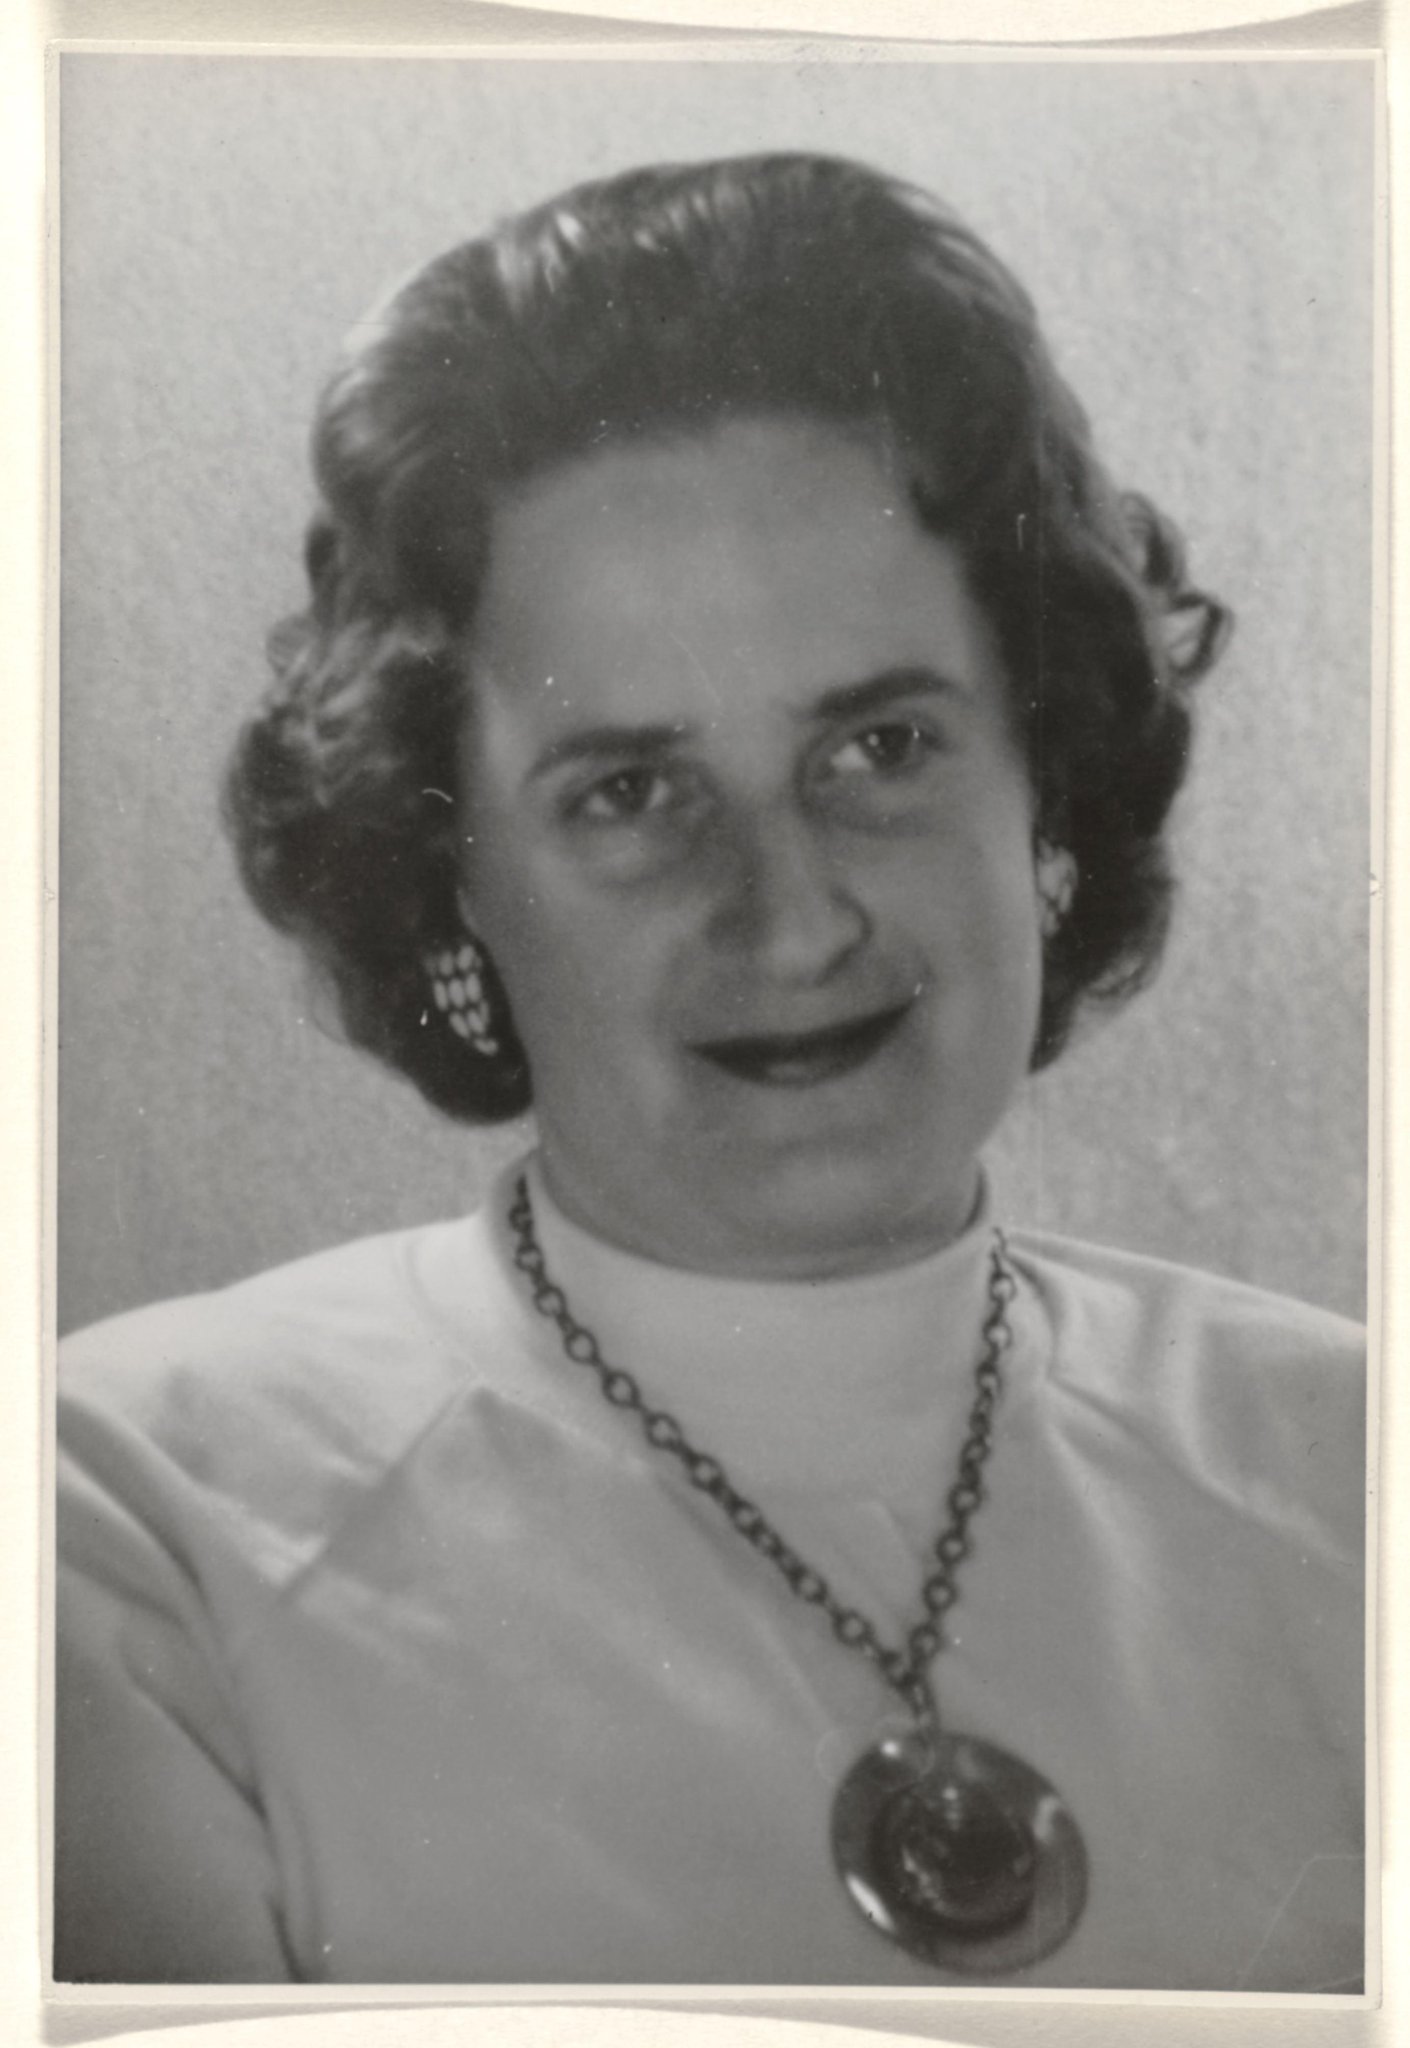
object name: photograph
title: Isabel Wachenheimer met coltrui en hanger met muzieknoten om haar nek, kijkend naar voren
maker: Anonymous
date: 1956-1973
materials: photographic support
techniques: gelatin silver print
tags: leiden, isabel wachenheimer-elon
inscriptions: number: ‘l 717’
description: Isabel Wachenheimer met coltrui en hanger met muzieknoten om haar nek, kijkend naar voren.